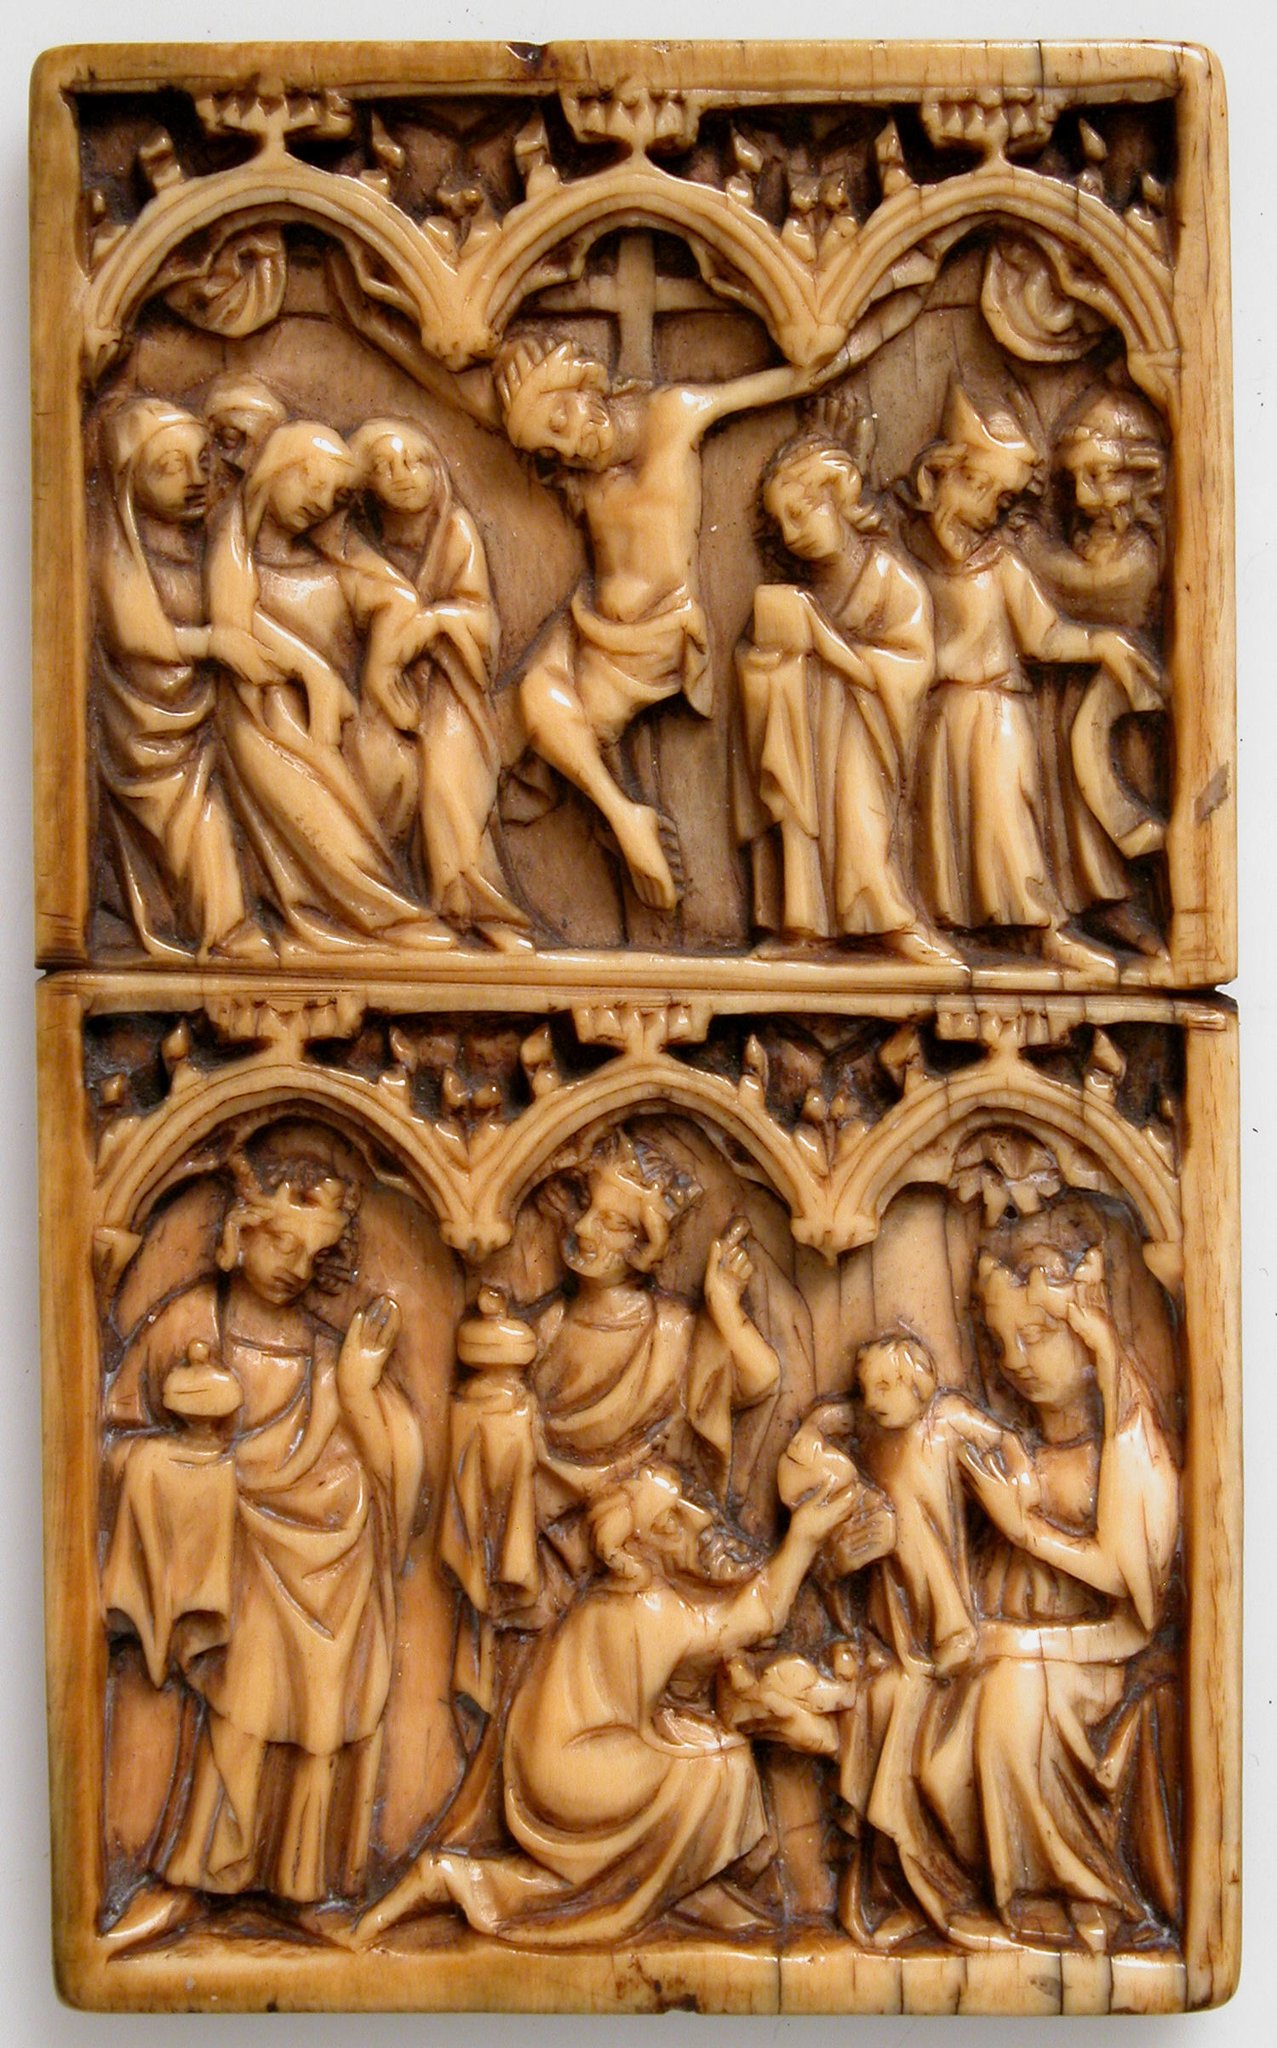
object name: writing tablet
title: Writing Tablet with Crucifixion and the Adoration of the Magi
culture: east french or rhenish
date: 1334-1366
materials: ivory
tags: christ,adoration of the magi,crucifixion